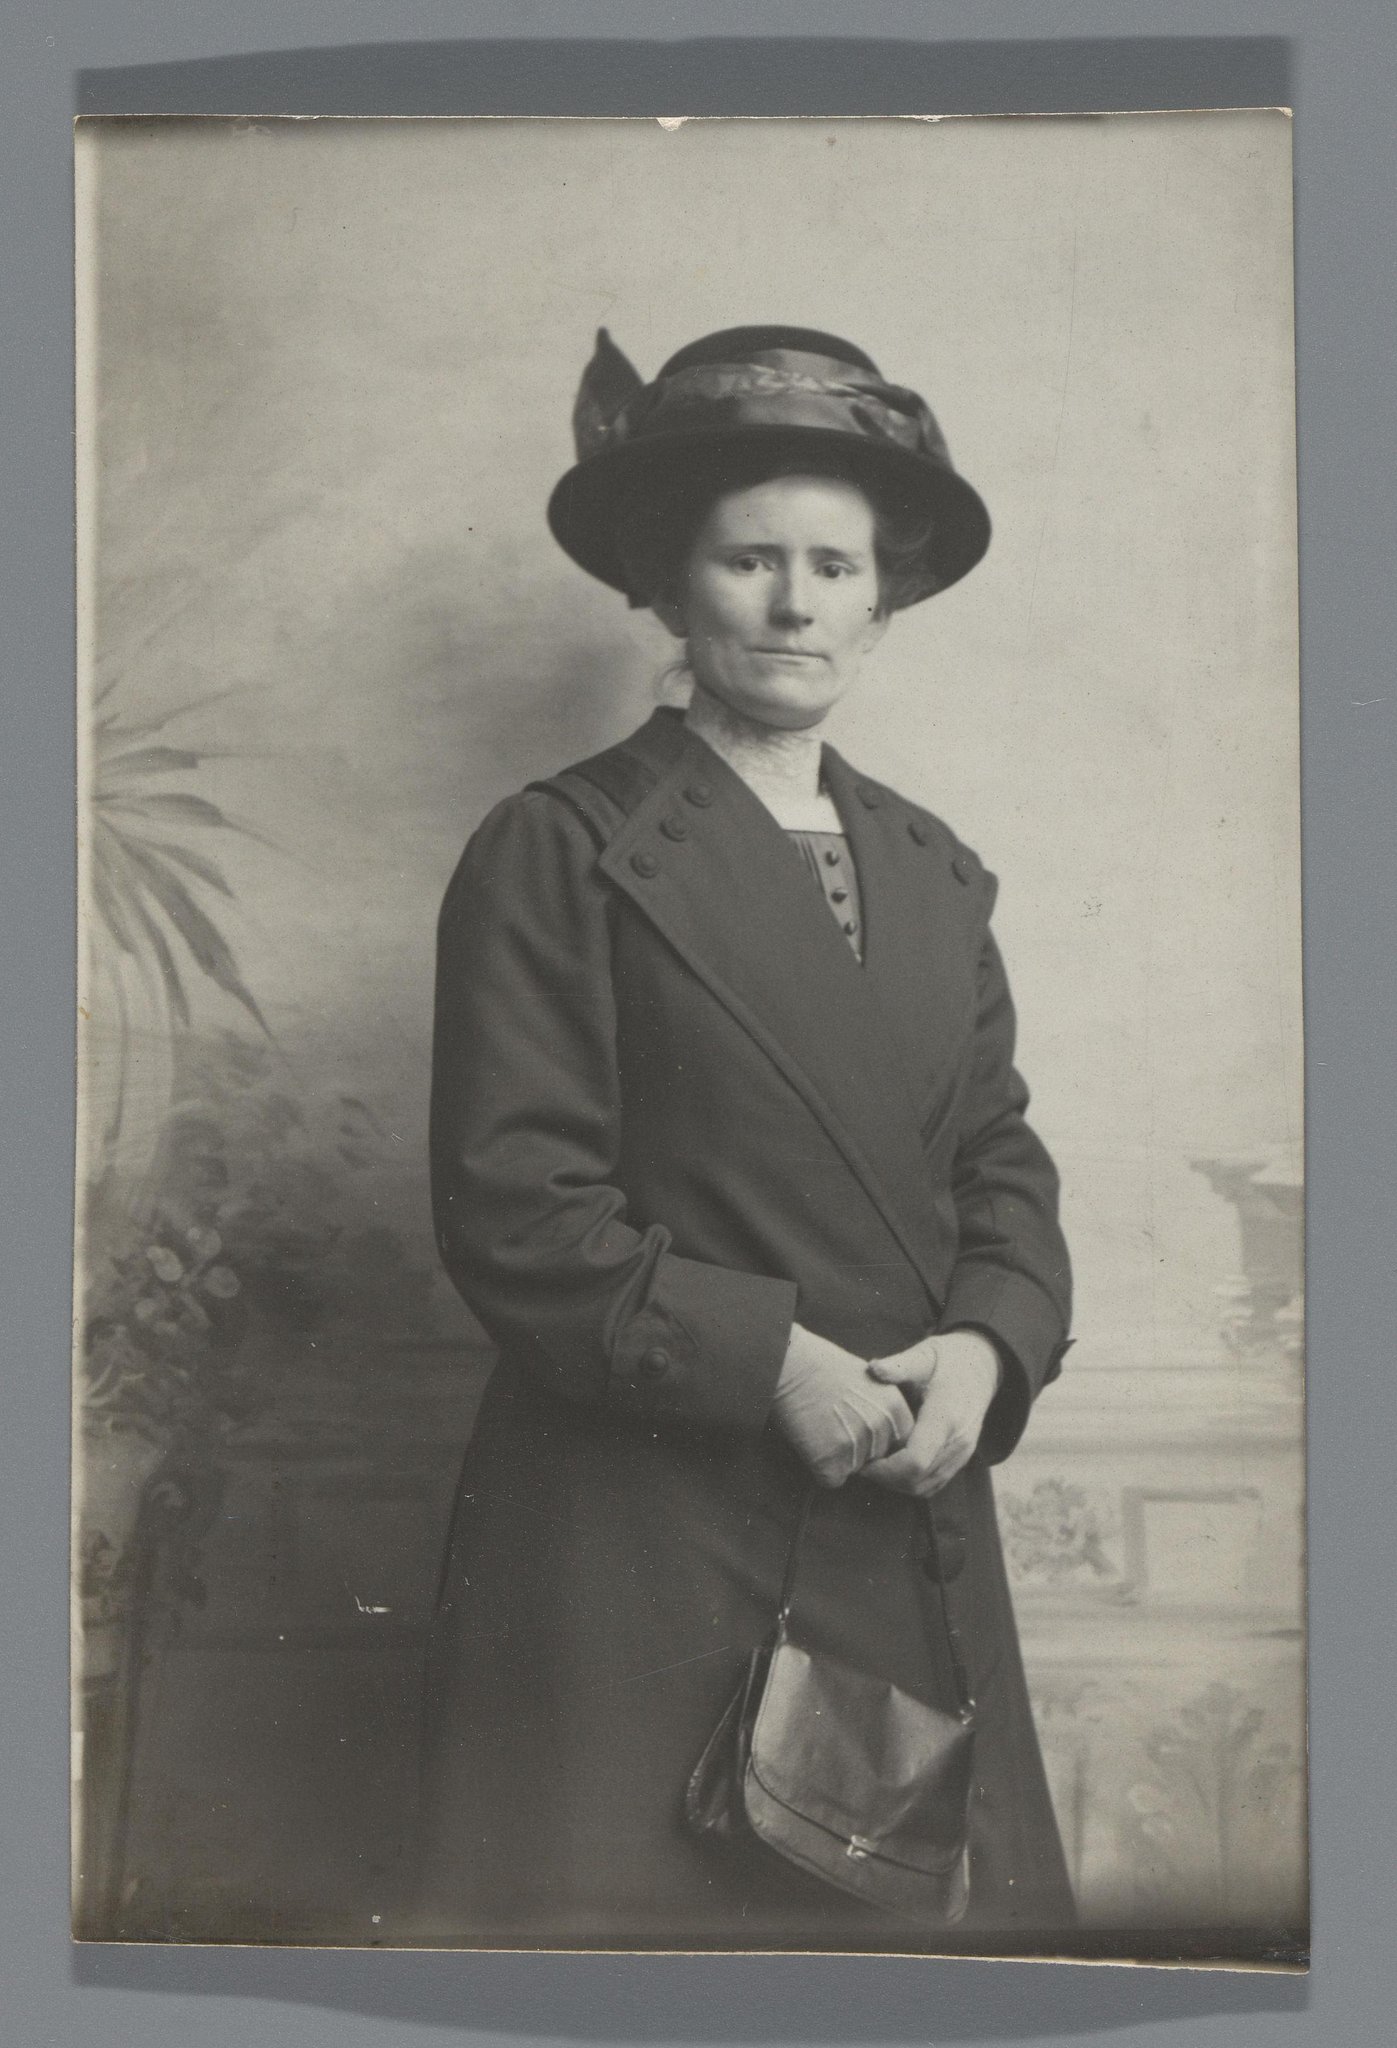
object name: snapshot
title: Portret van een vrouw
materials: photographic support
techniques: gelatin silver print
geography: groningen